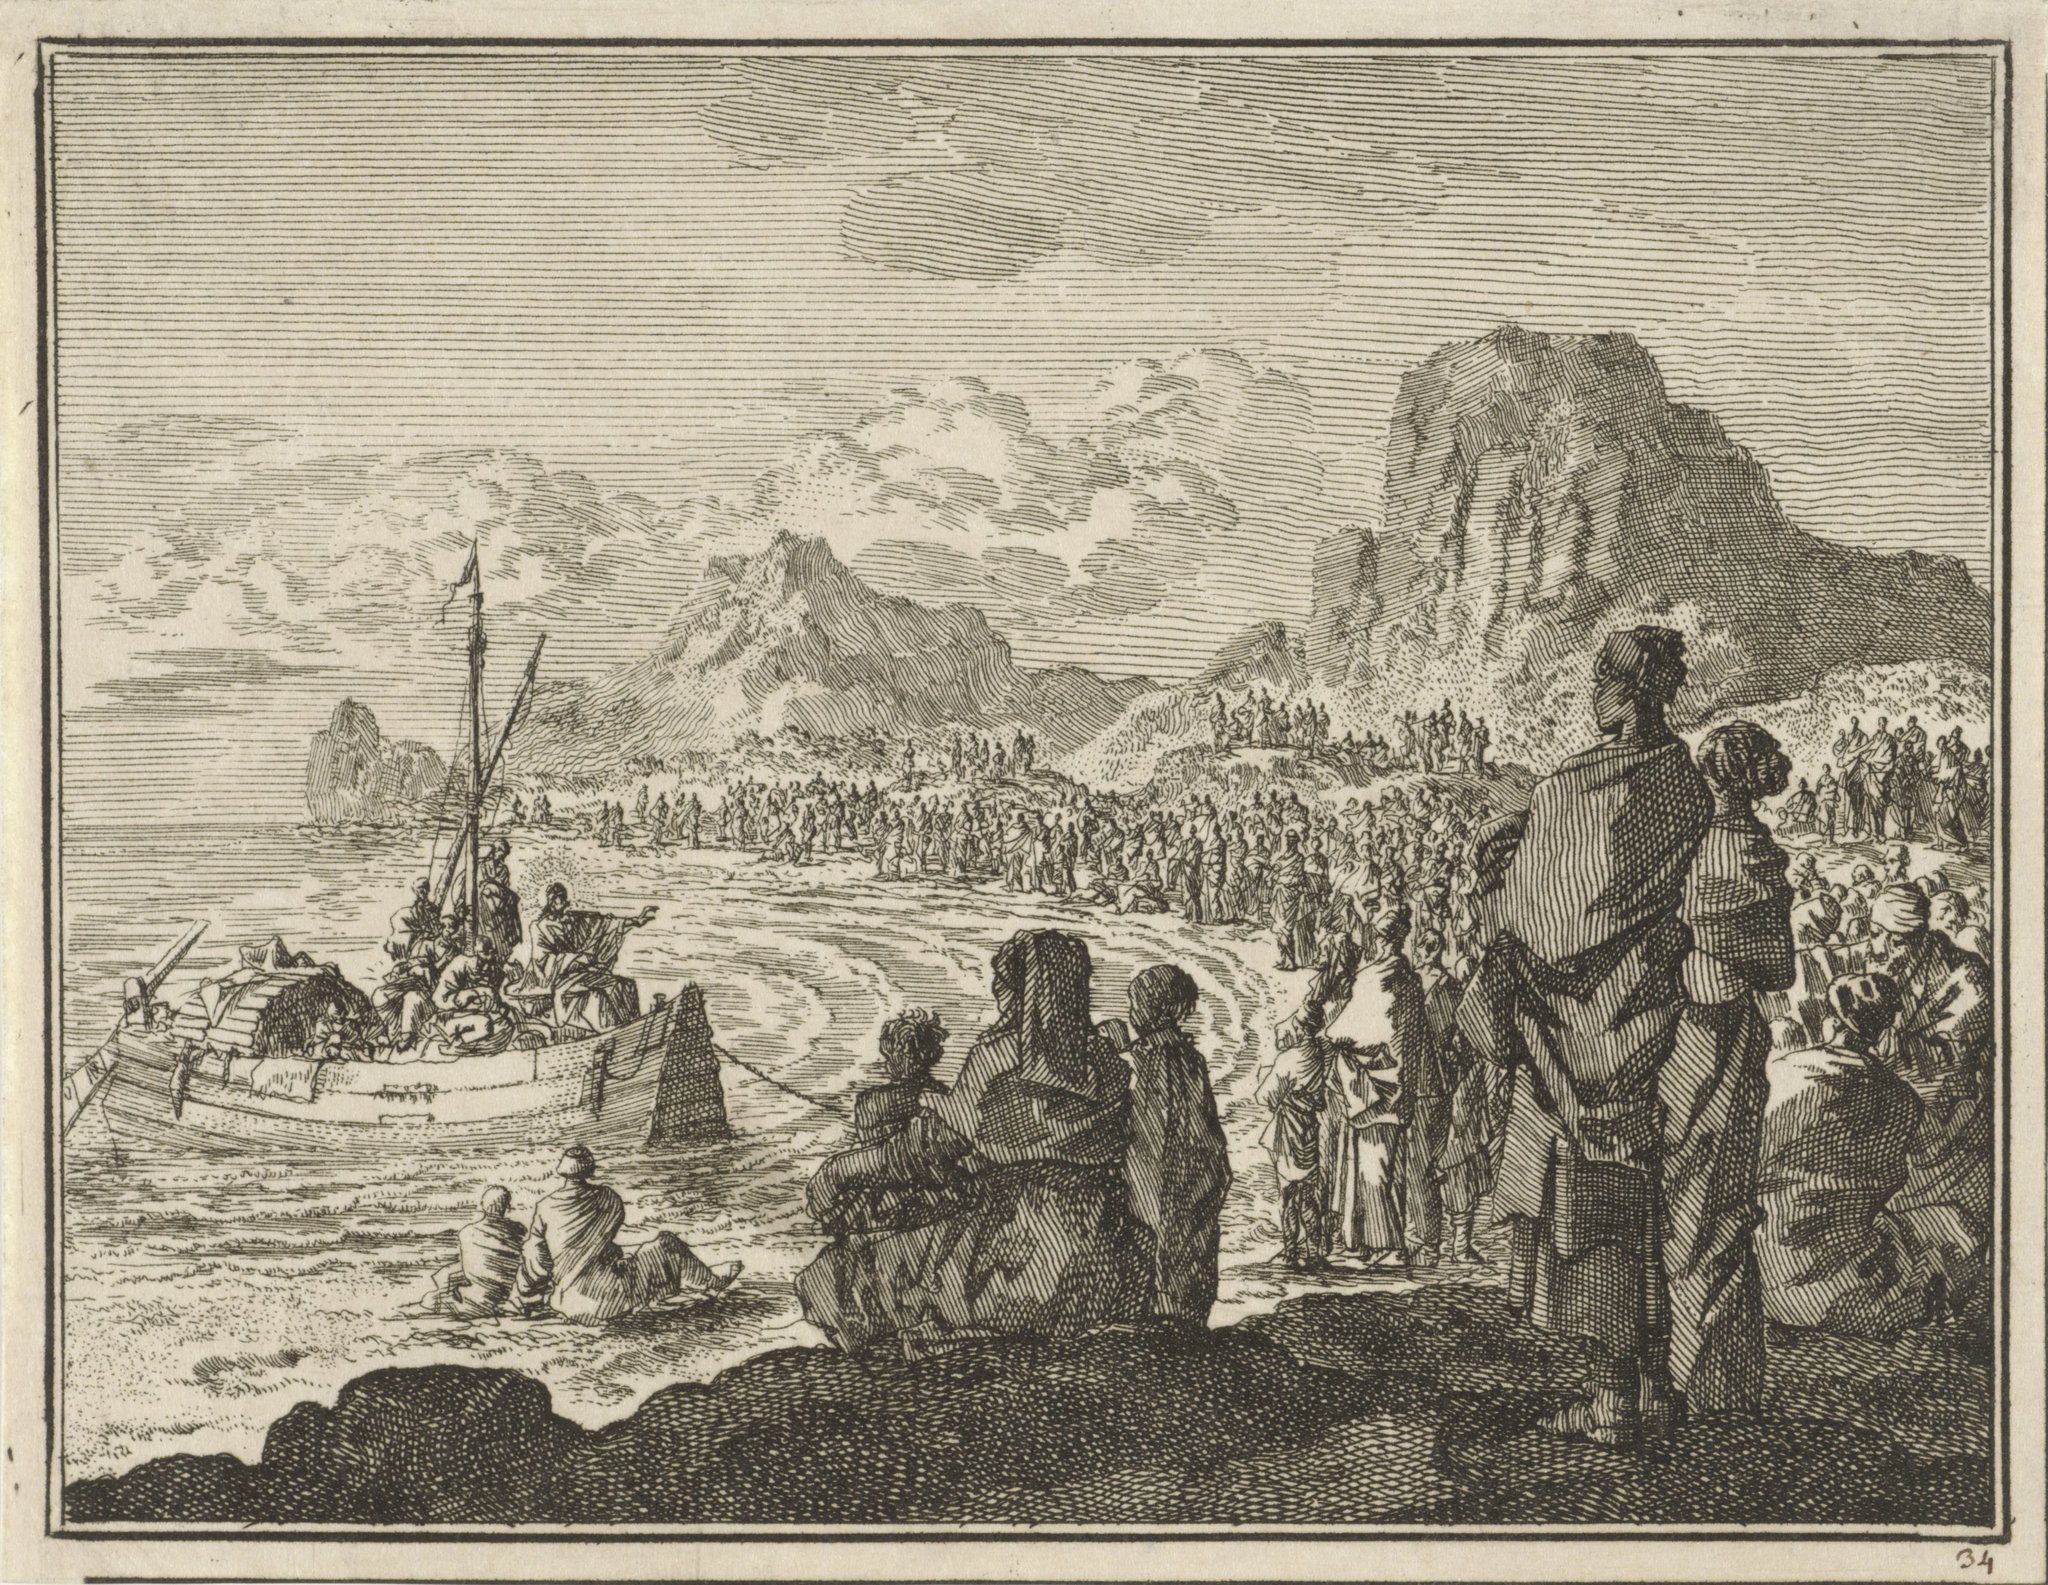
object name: print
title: Christus predikend vanaf een boot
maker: jan luyken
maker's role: draughtsman, print maker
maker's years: 1649-1712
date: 1712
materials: paper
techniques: etching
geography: amsterdam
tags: christ preaching from a boat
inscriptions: collector's mark: Lugt 2228, number: ‘34’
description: Proefdruk van illustratie uit: Luyken, Jan. De schriftuurlyke geschiedenissen en gelykenissen van het Oude en Nieuwe Verbond, 2 delen. Amsterdam: Wed. Pieter Arentsz II en Cornelis van der Sys, 1712, dl. II.